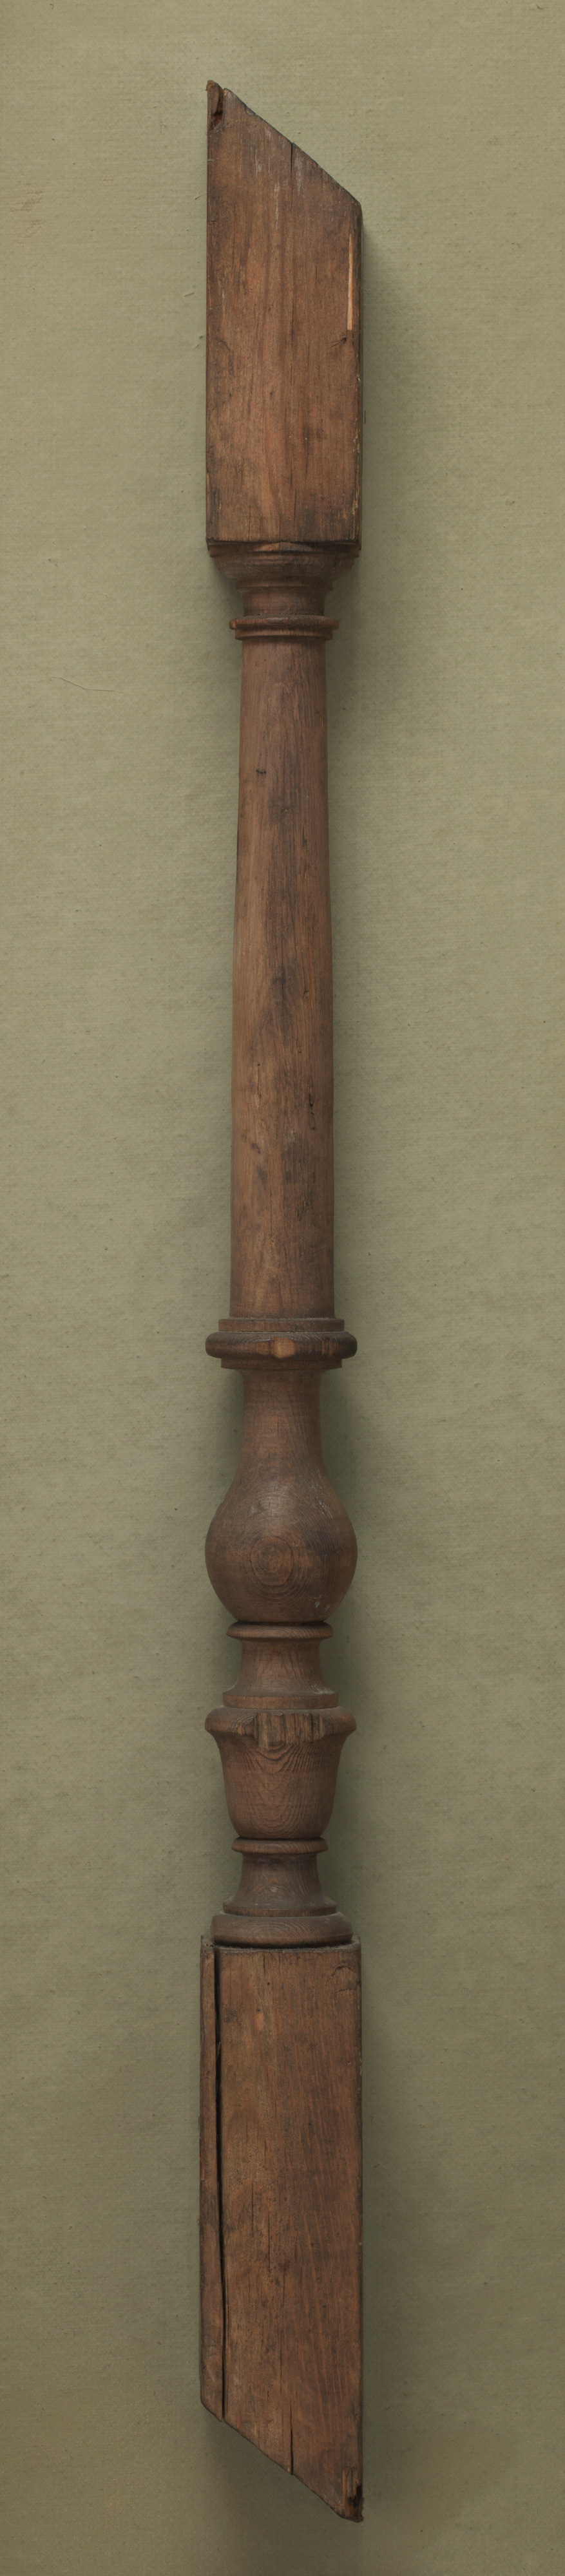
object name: baluster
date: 1701-1750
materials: wood